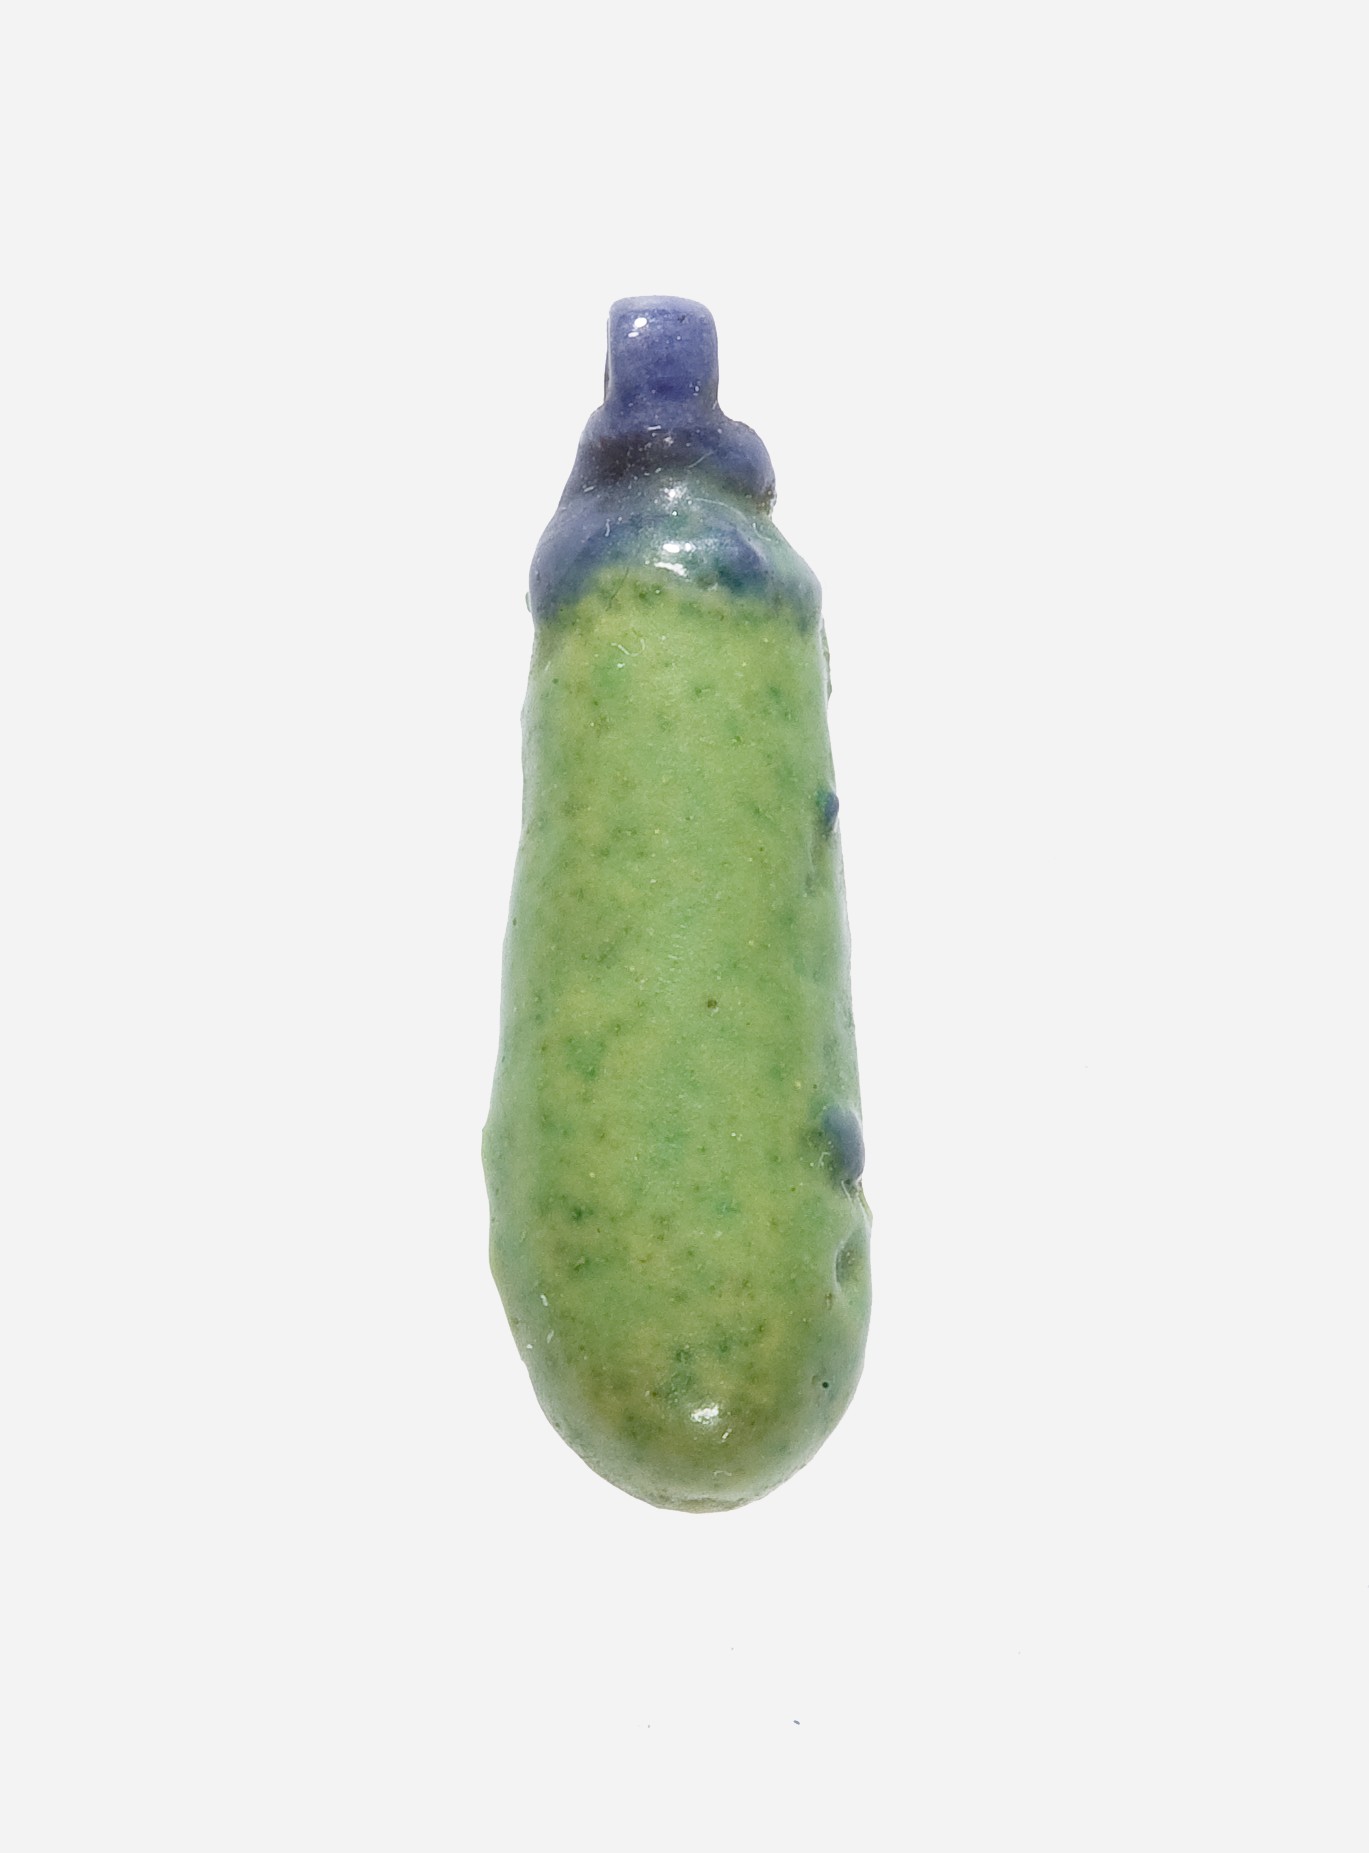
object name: pendant, date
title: Date Pendant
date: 1390-1352 BCE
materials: faience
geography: egypt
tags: fruit